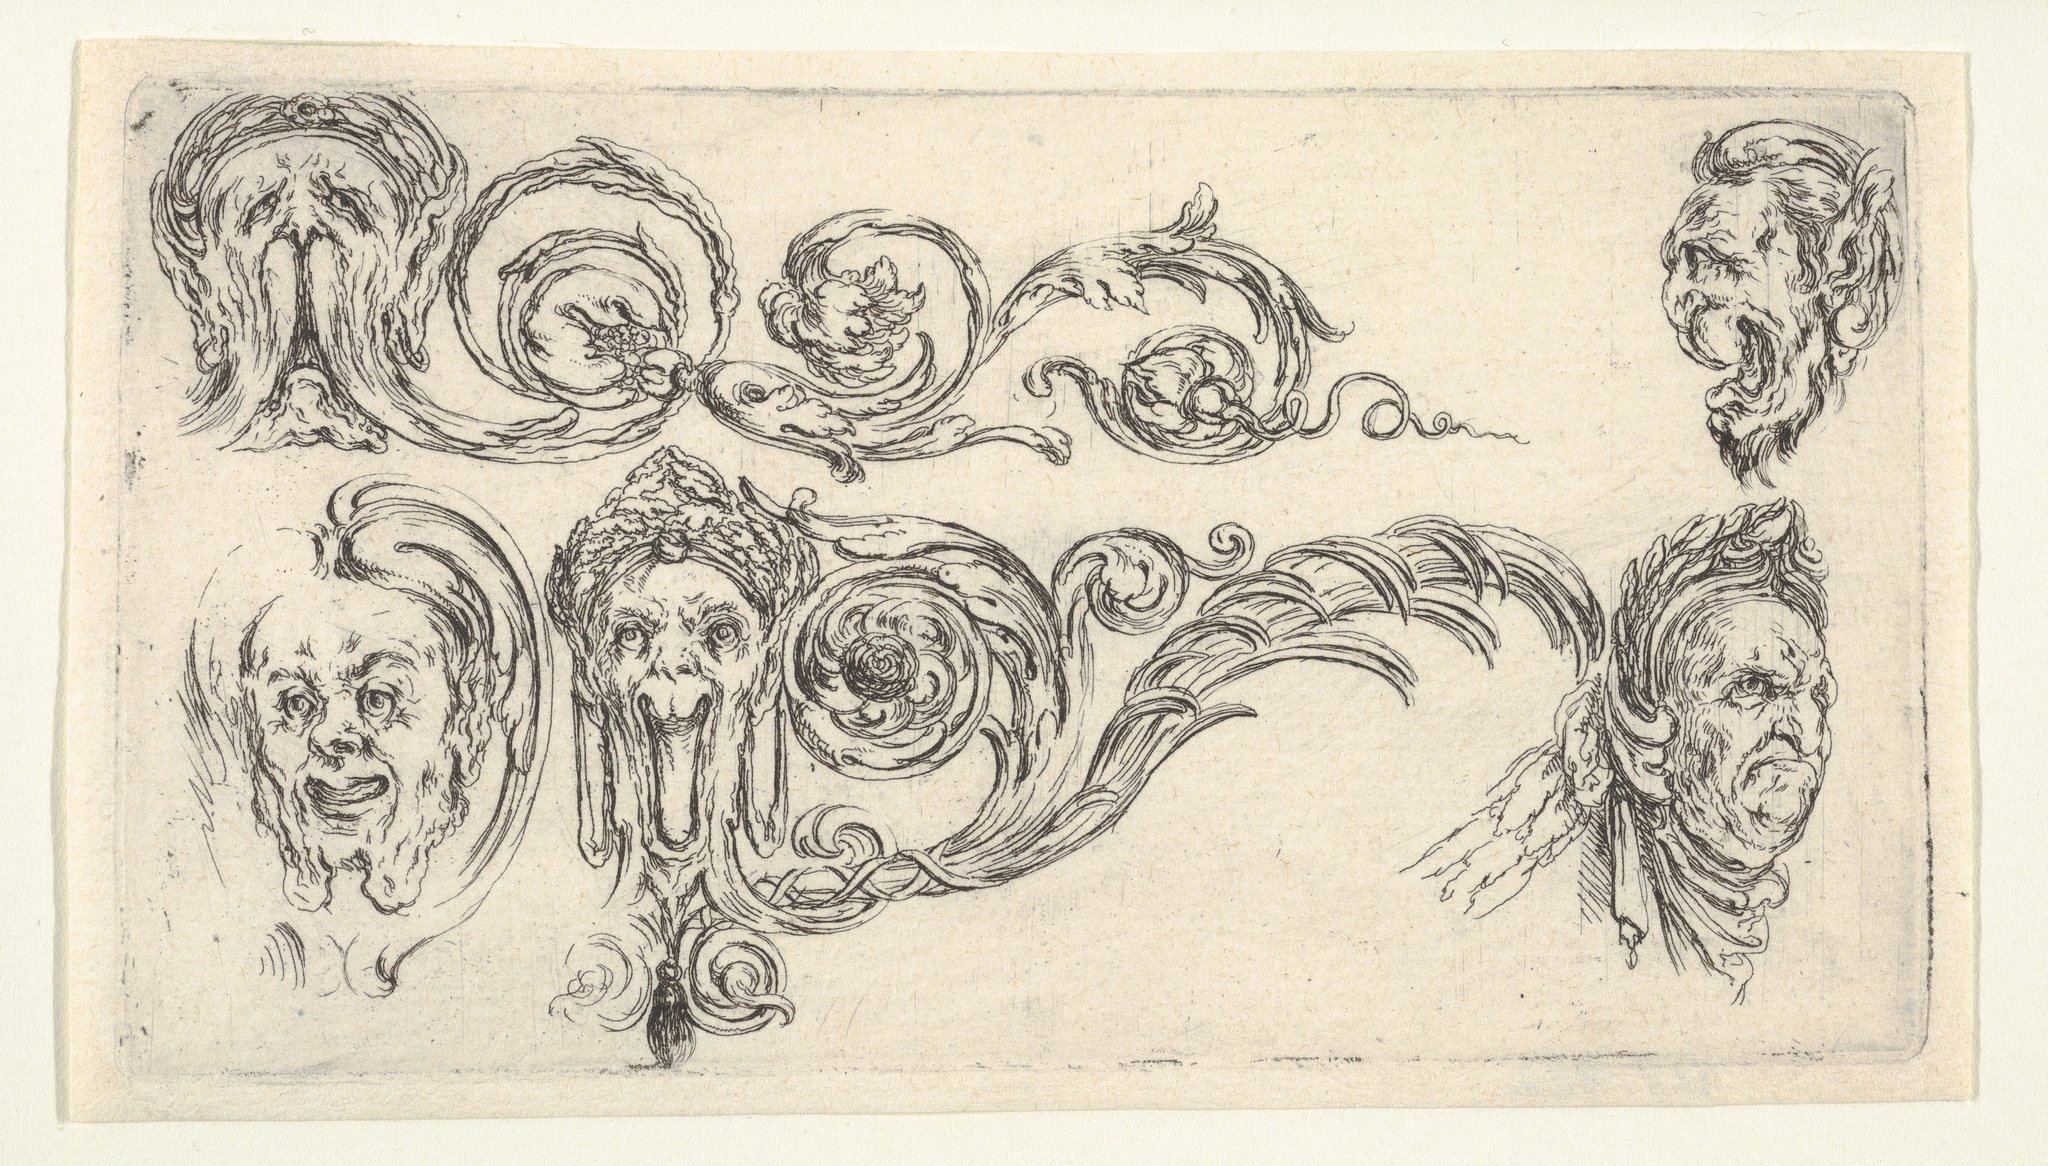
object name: print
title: Five grotesque heads, plate 4 from "Friezes, foliage, and grotesques" (Frises, feuillages et grotesques)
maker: stefano della bella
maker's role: artist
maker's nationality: italian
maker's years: 1610-1664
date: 1638-1643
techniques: etching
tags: ornament,heads